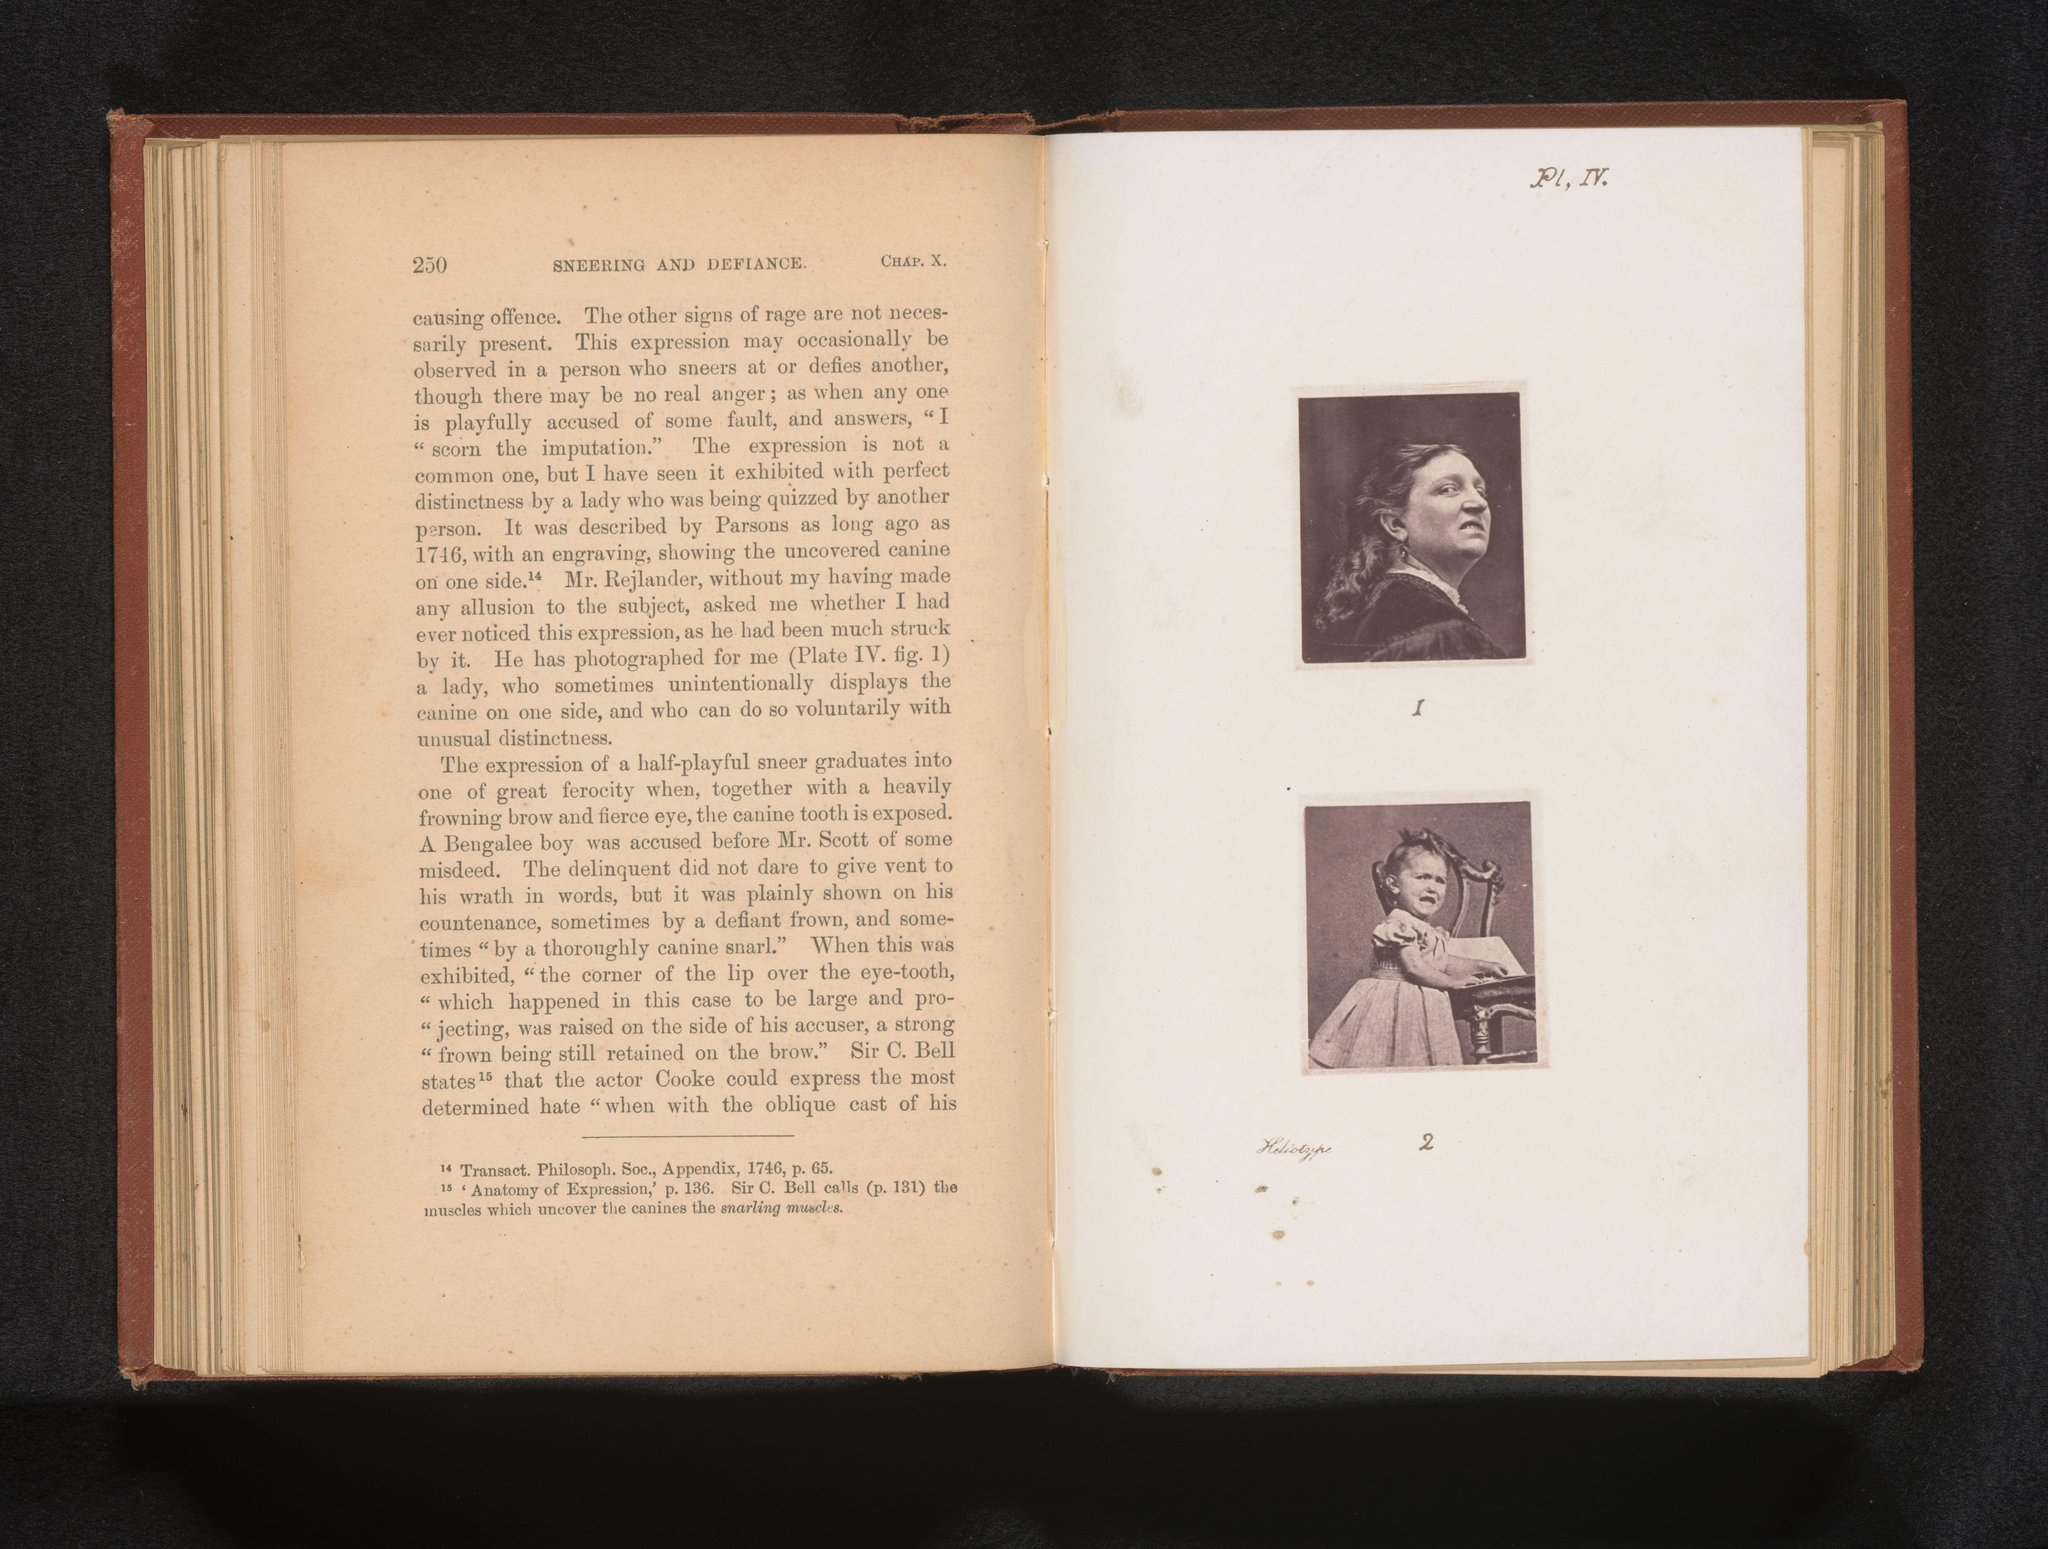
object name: photomechanical print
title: Twee portretten van een onbekende vrouw en een kind die woede en spot tonen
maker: Anonymous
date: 1863-1873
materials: paper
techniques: heliotype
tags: passions, emotions, affections, rage, anger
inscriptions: number: ‘Pl. IV. 1 2’